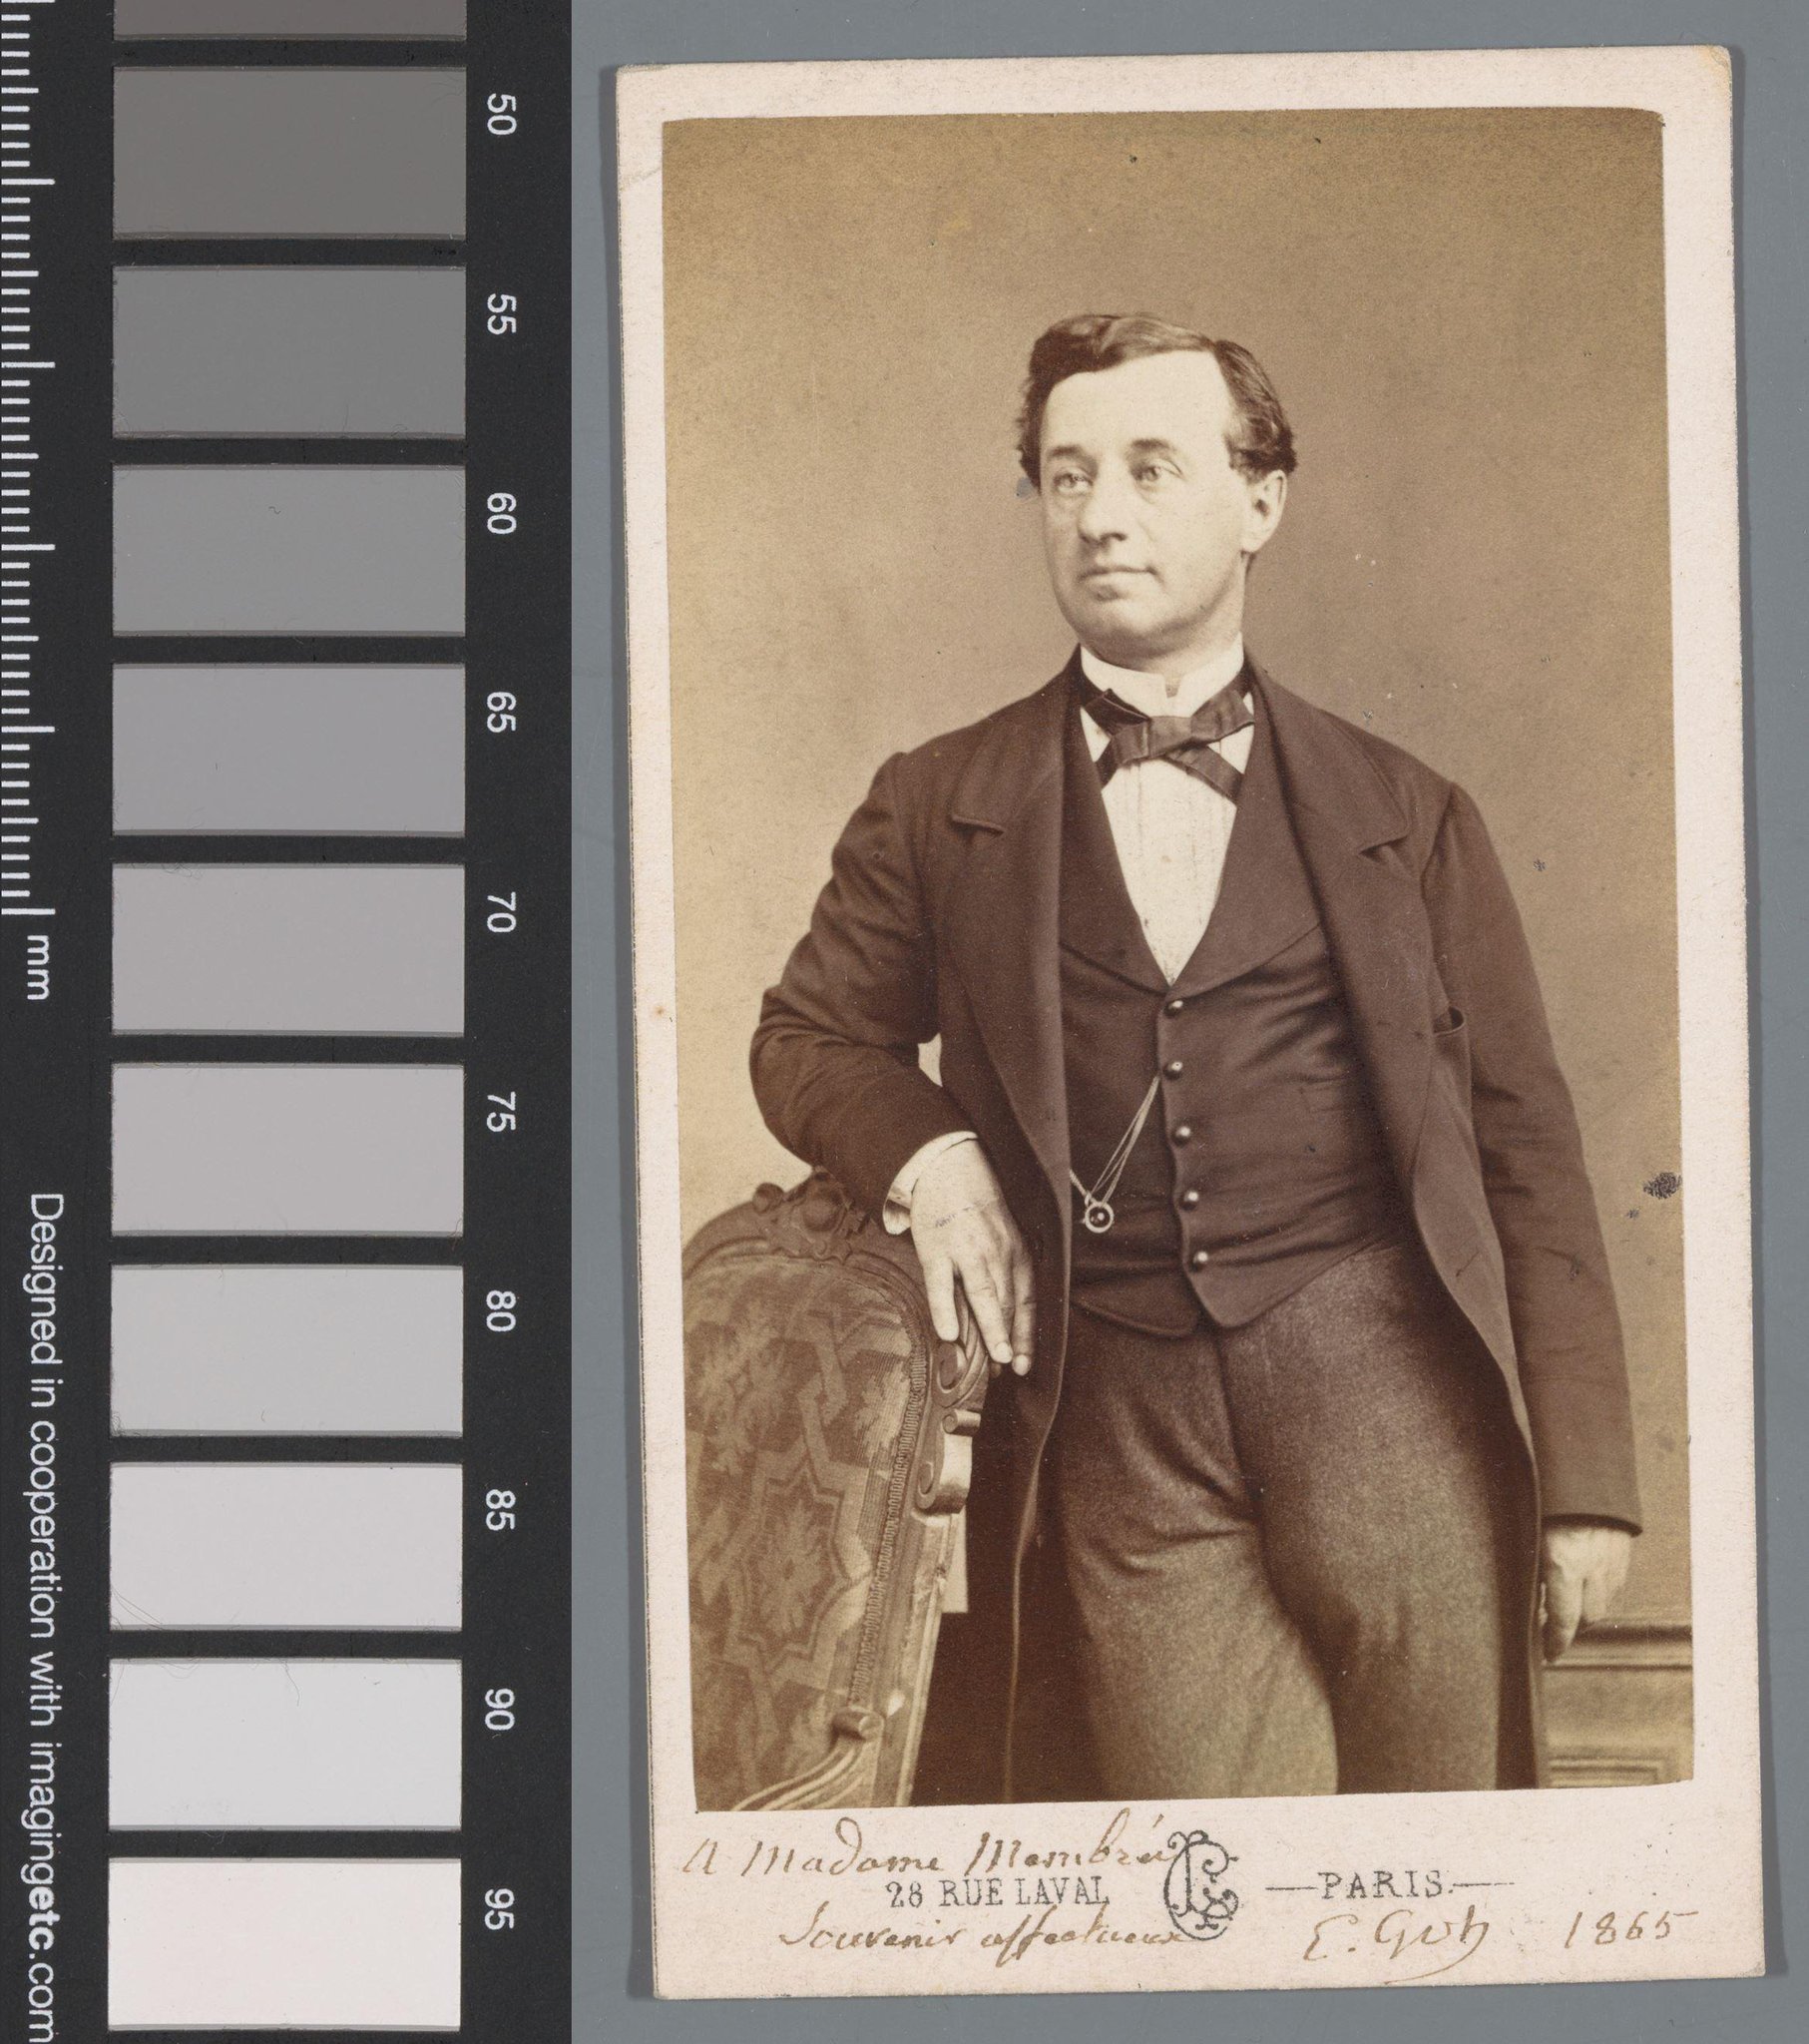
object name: carte de visite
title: Portret van E. Gotz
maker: léon cremière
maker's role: fotograaf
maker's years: 1831-1913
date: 1865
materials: cardboard, paper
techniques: albumen print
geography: paris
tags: adult man, historical persons, paris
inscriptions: inscription: ‘27 Rue Laval Paris’, monogram: ‘LC’, inscription: ‘A Madame Membré/ Souvenir affectueuse/ E. Gotz 1865’, inscription: ‘L. Cremière & Cie./ photographes/ de la Maison de l'Empereur./ 28, Rue Laval Paris.’